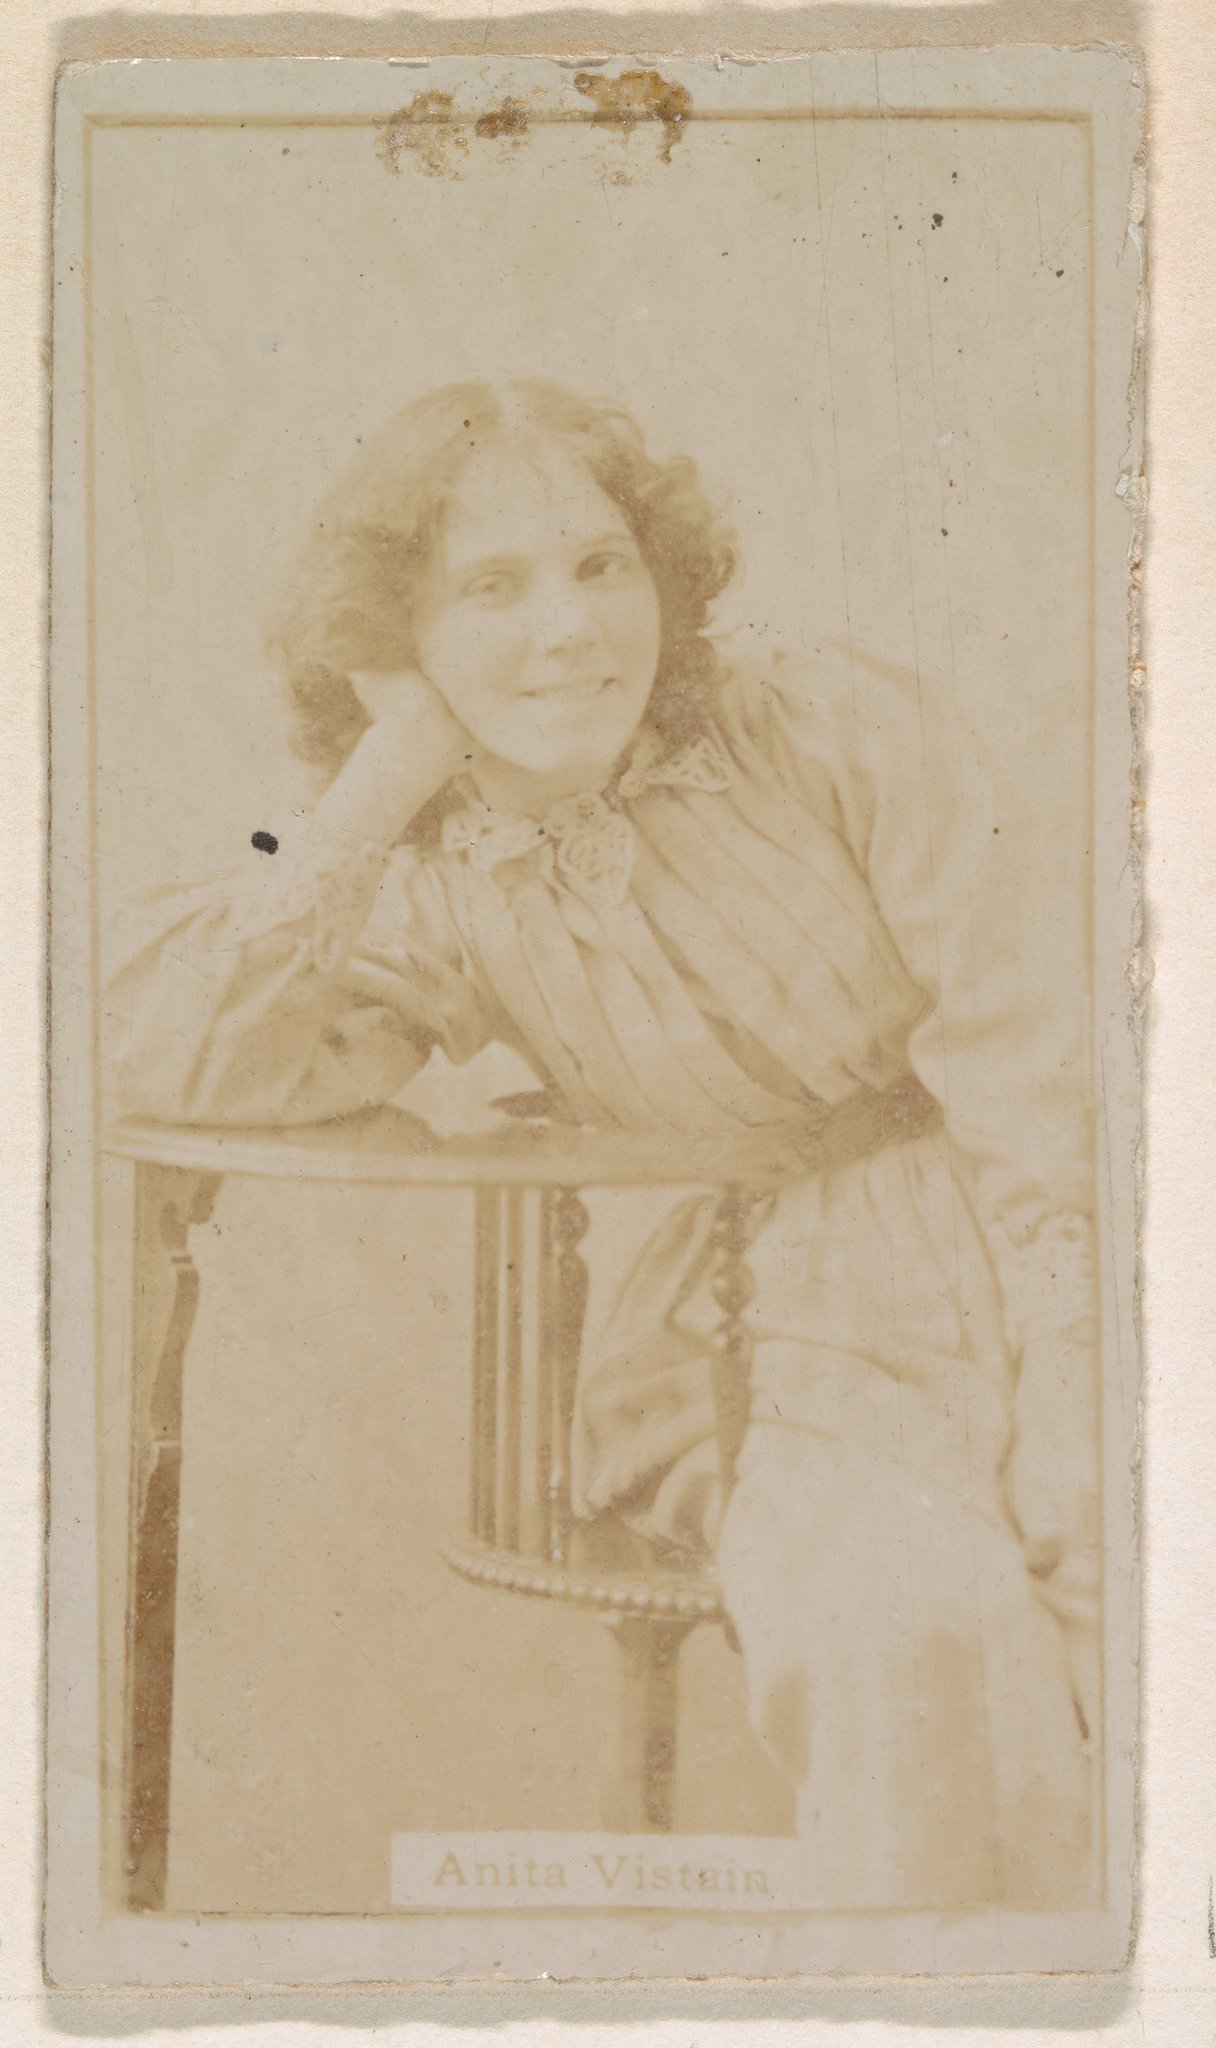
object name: photograph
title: Anita Vistain, from the Actresses series (N245) issued by Kinney Brothers to promote Sweet Caporal Cigarettes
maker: kinney brothers tobacco company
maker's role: publisher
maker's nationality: american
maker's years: 1869-2011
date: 1890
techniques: albumen silver print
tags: portraits,women,actresses